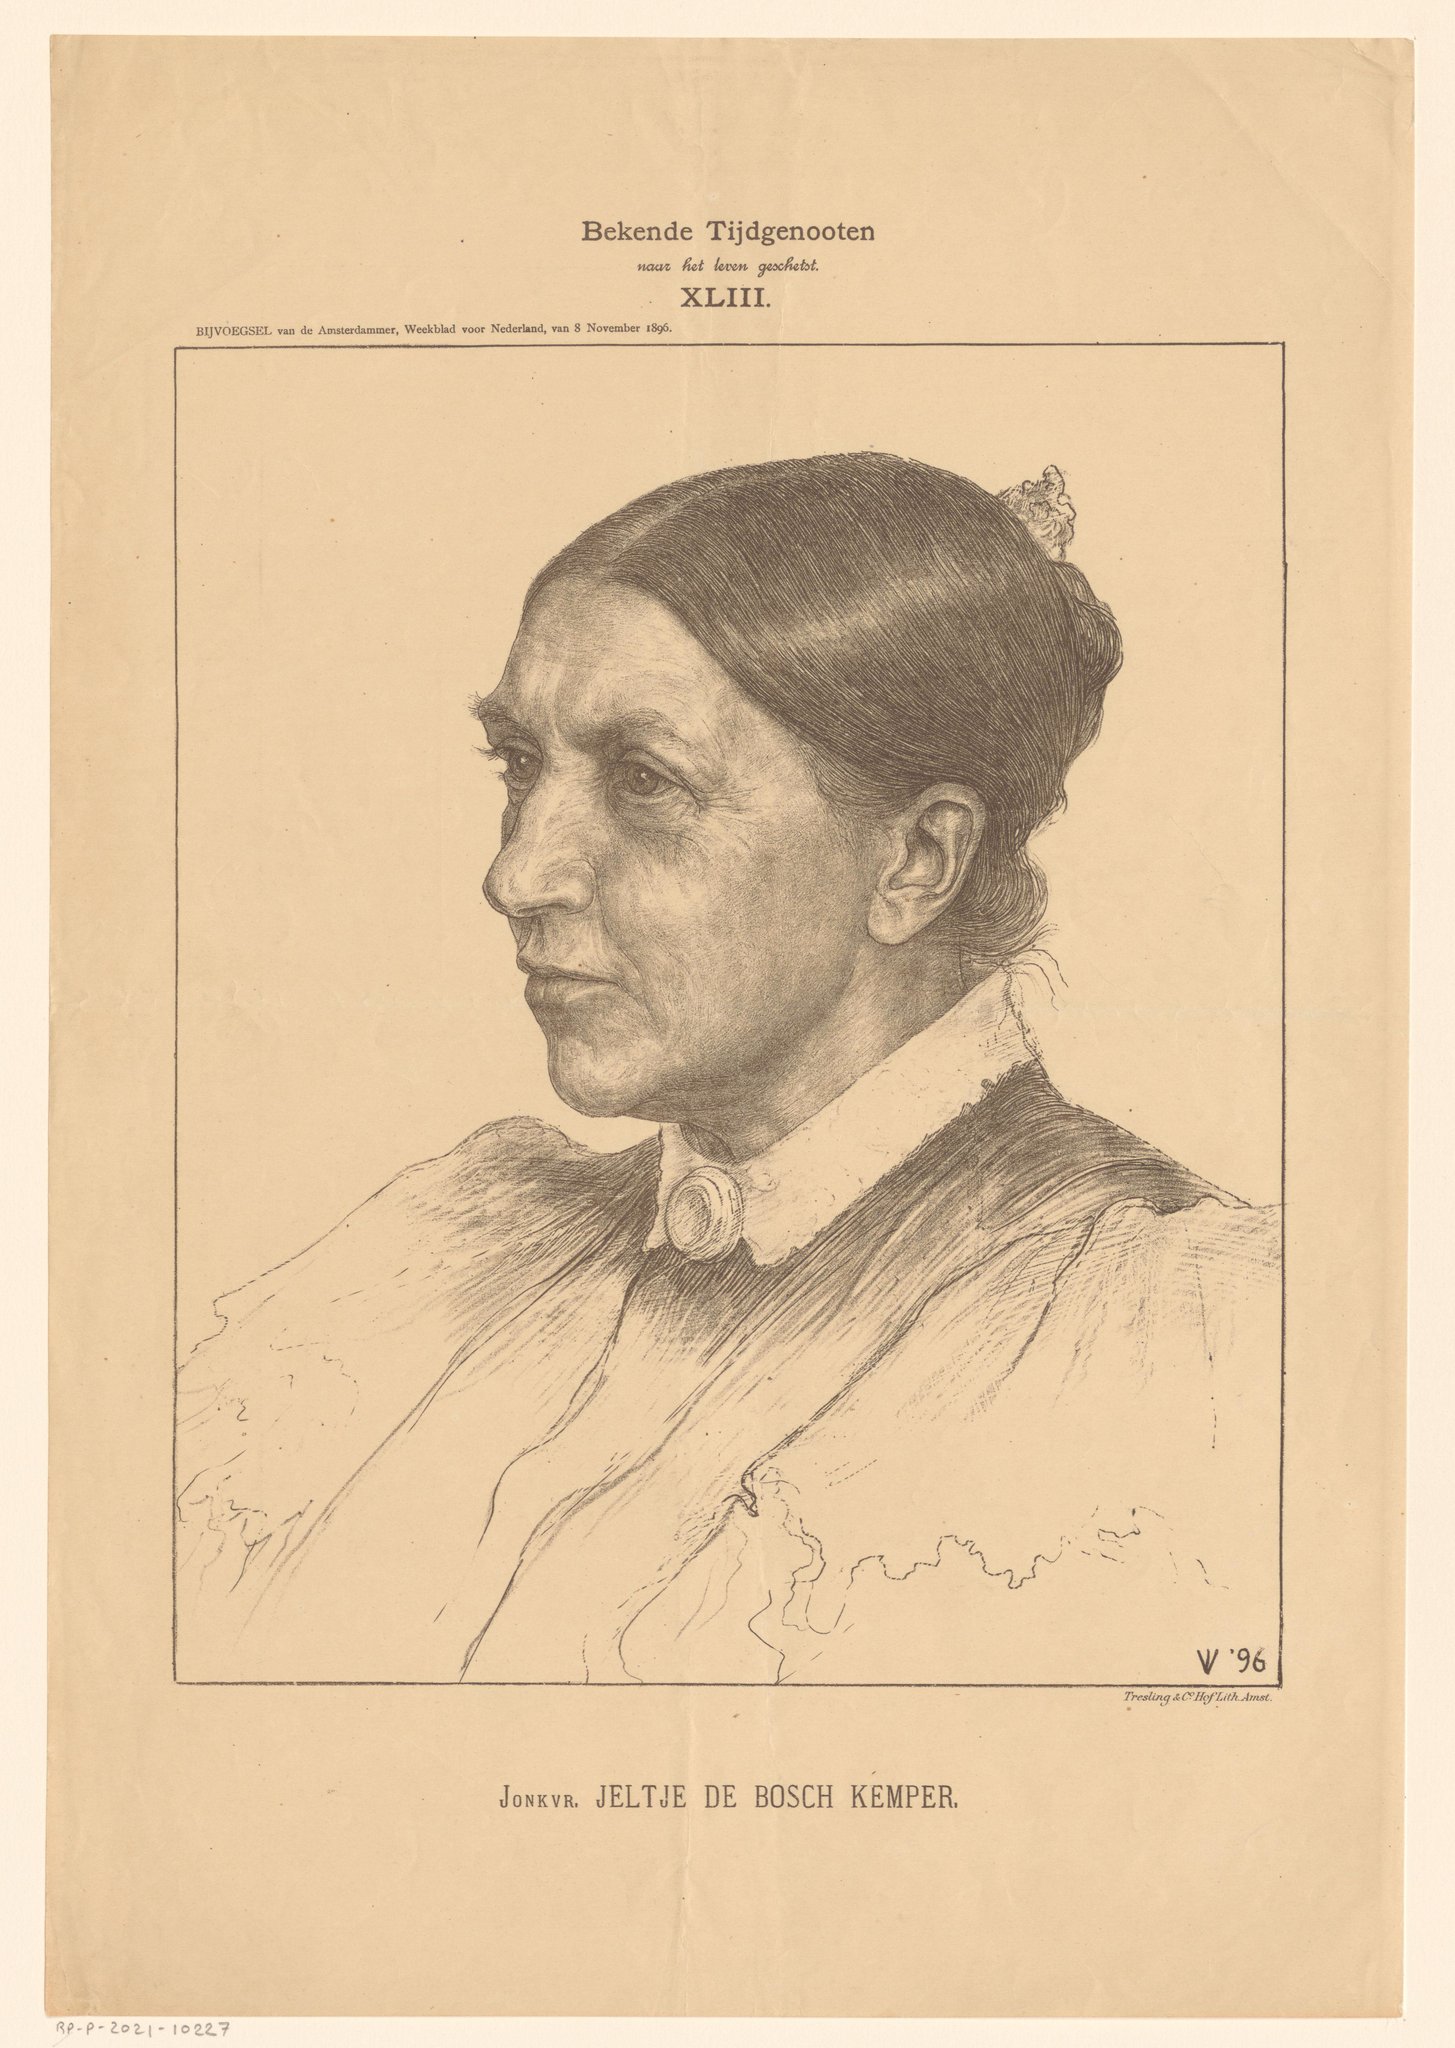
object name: print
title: Bekende tijdgenooten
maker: jan veth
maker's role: designer, draughtsman, painter, print maker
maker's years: 1864-1925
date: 1896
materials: paper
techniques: lithograph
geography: amsterdam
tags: amsterdam, historical persons - bb - woman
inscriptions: collector's mark: Lugt 2228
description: Verschenen in het bijvoegsel van: De Amsterdammer, Weekblad voor Nederland, 8 november 1896.